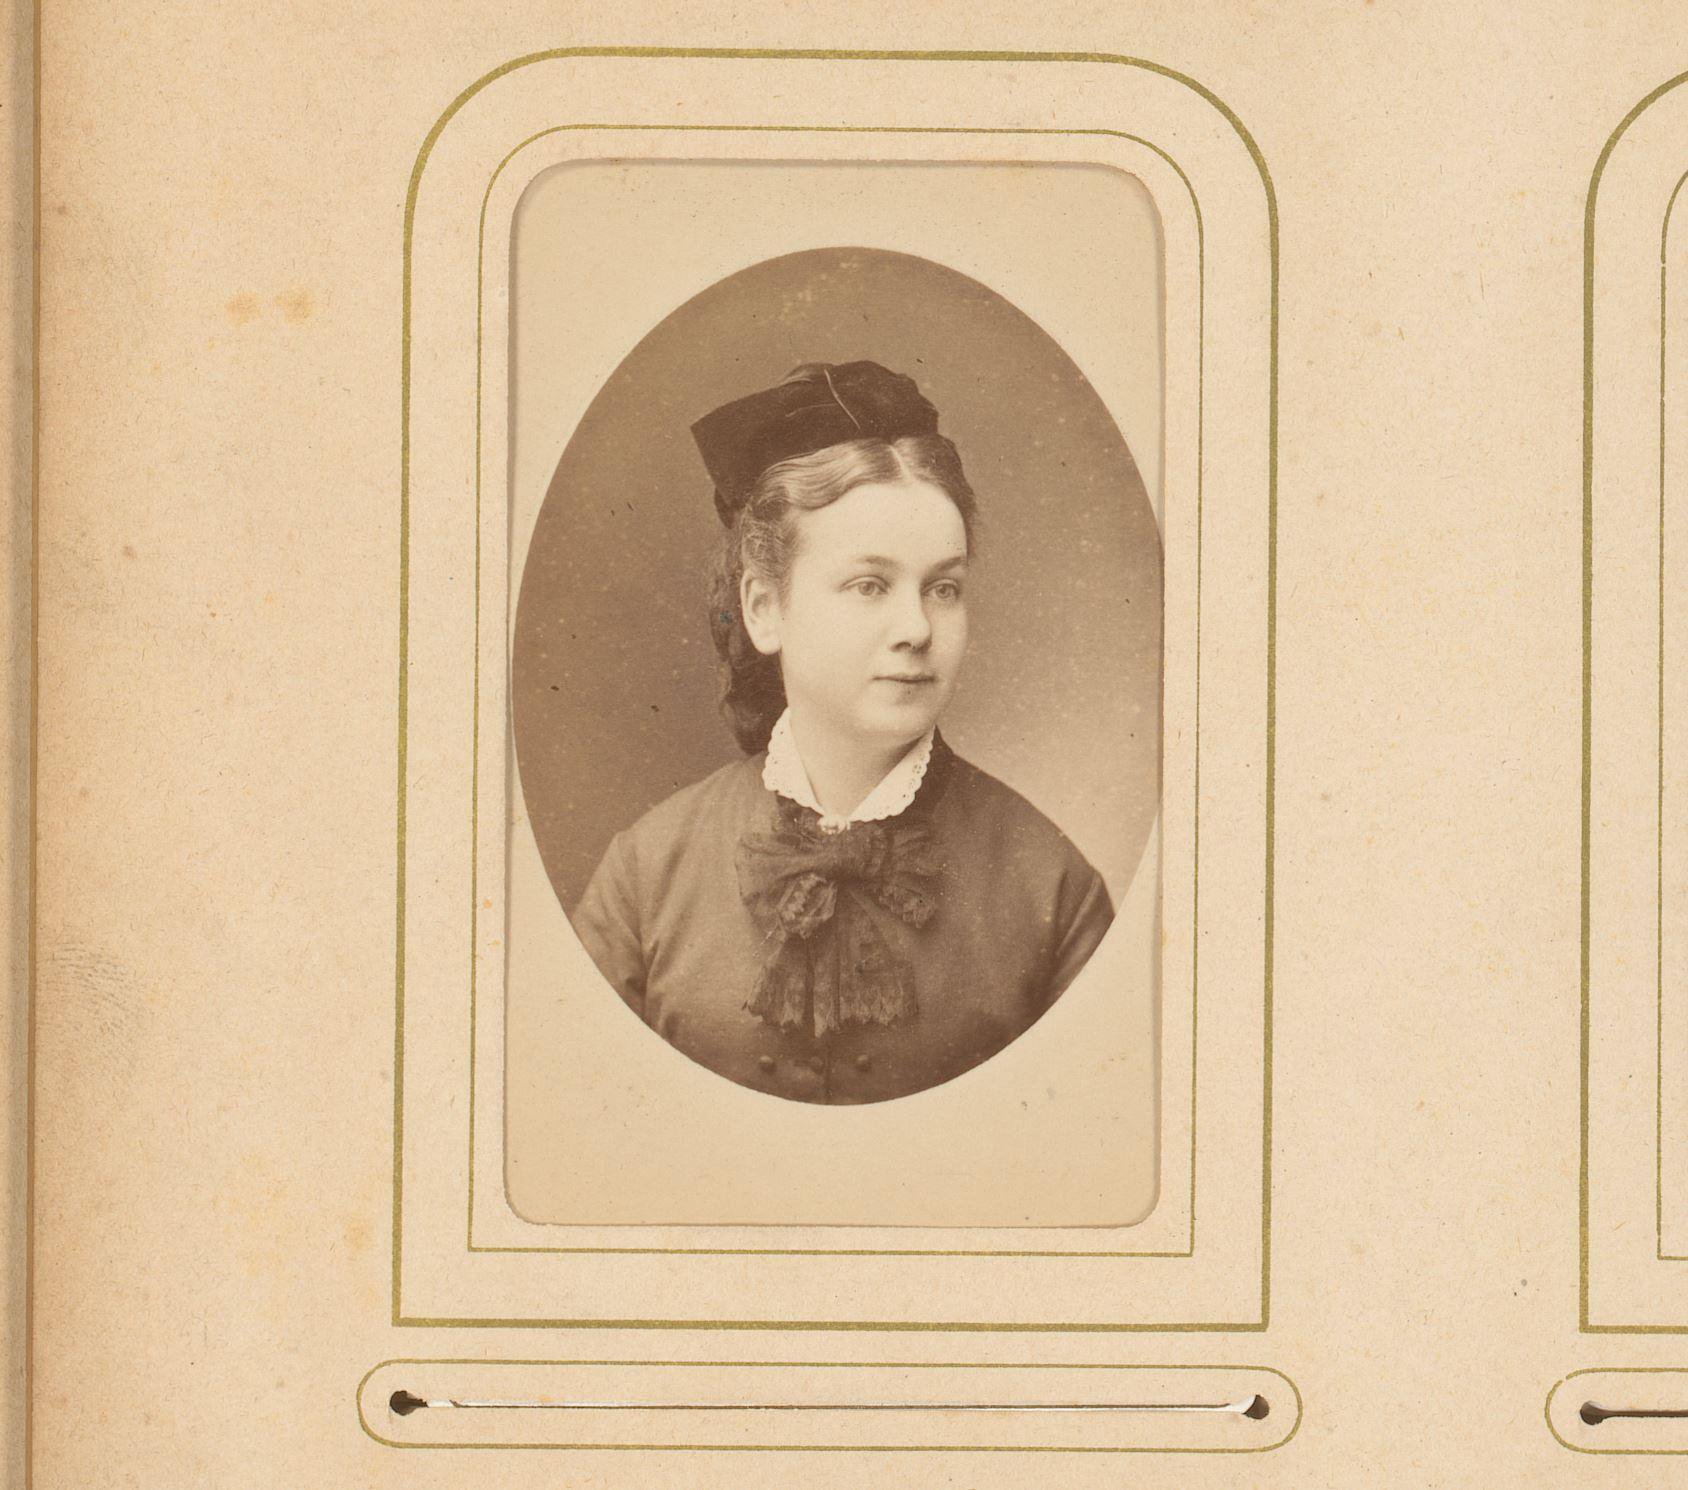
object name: album leaf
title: Portret van een jonge vrouw met lint in haar haren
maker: carel eduard westerborg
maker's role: fotograaf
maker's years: 1842-1916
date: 1861-1900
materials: cardboard, photographic support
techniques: albumen print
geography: rotterdam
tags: adolescent, young woman, maiden, historical persons - bb - woman, hairdress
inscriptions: inscription: ‘C. E. WESTERBORG/ Photograaf/ Vossenstraat B 66/ Arnhem/ Voor nabestelling worden alle/ negatieven bewaard’